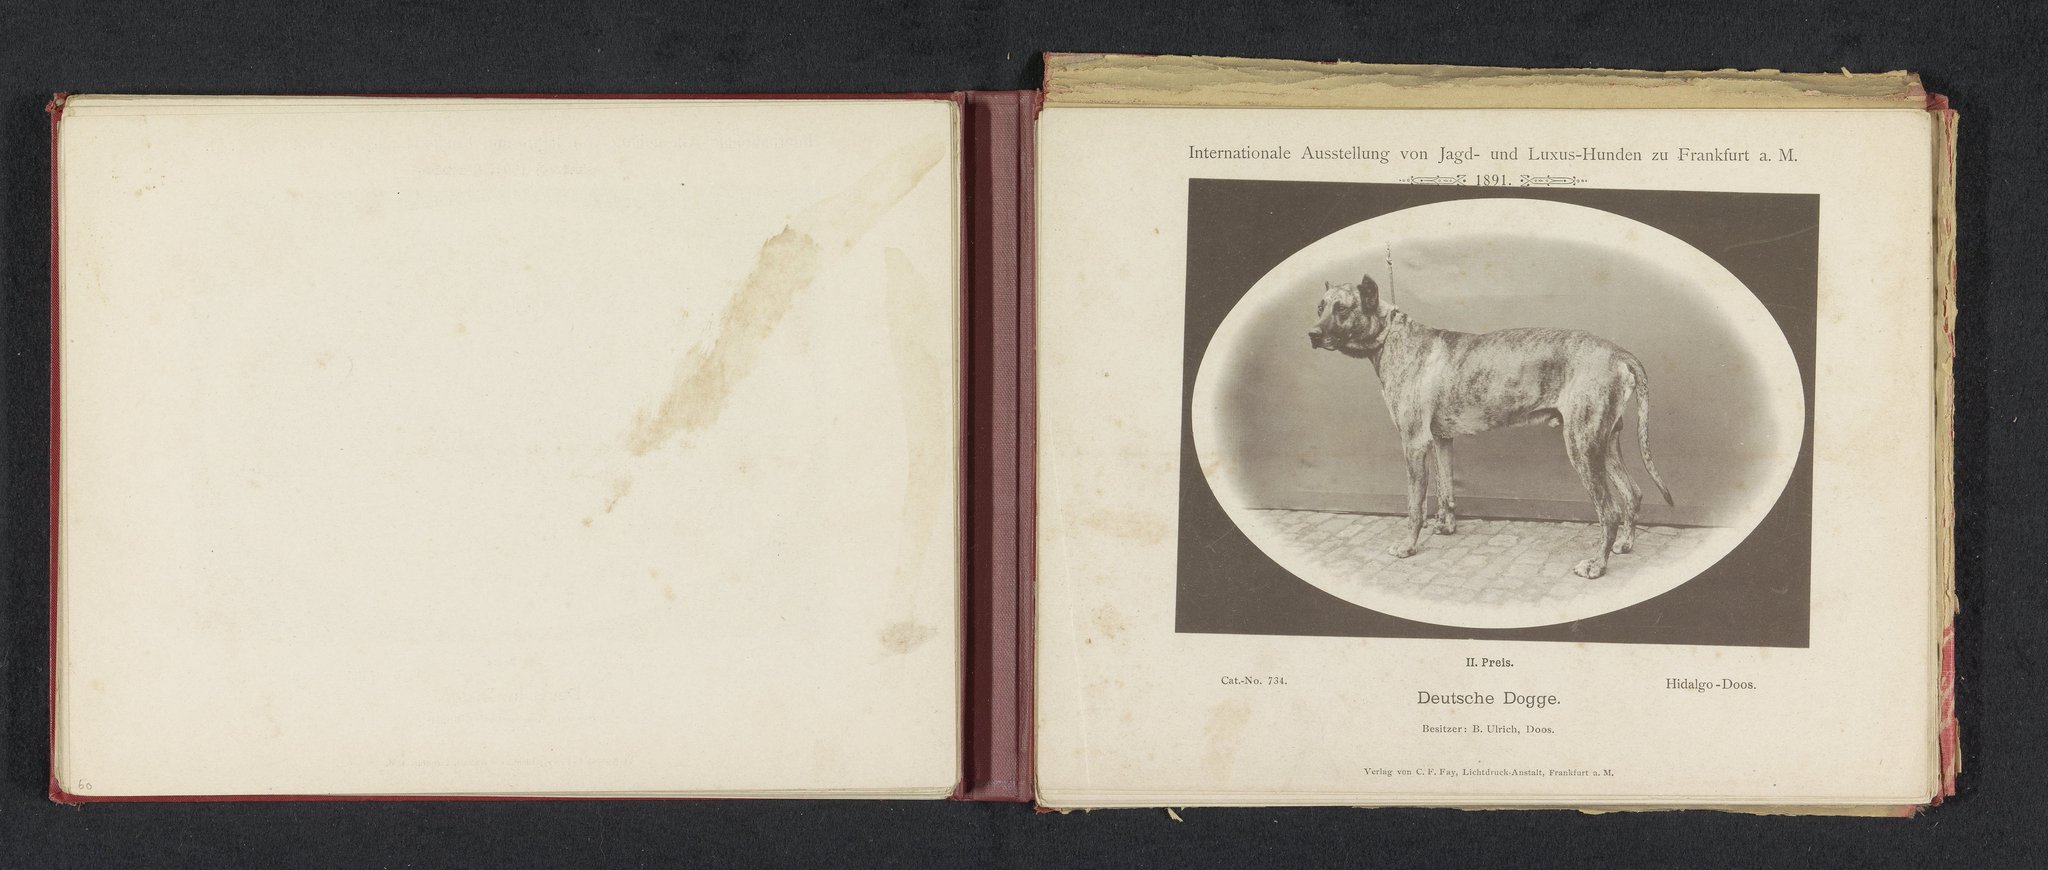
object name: photomechanical print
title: Duitse dog Hidalgo die een tweede prijs heeft gewonnen op de Internationale Ausstellung von Jagd und Luxus Hunden in 1891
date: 1891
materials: paper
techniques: photograph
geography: frankfurt am main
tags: dog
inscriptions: inscription: ‘II. Preis. Hidalgo-Doos. Besitzer : B. Ulrich, Doos.’, number: ‘Cat.-No. 734.’